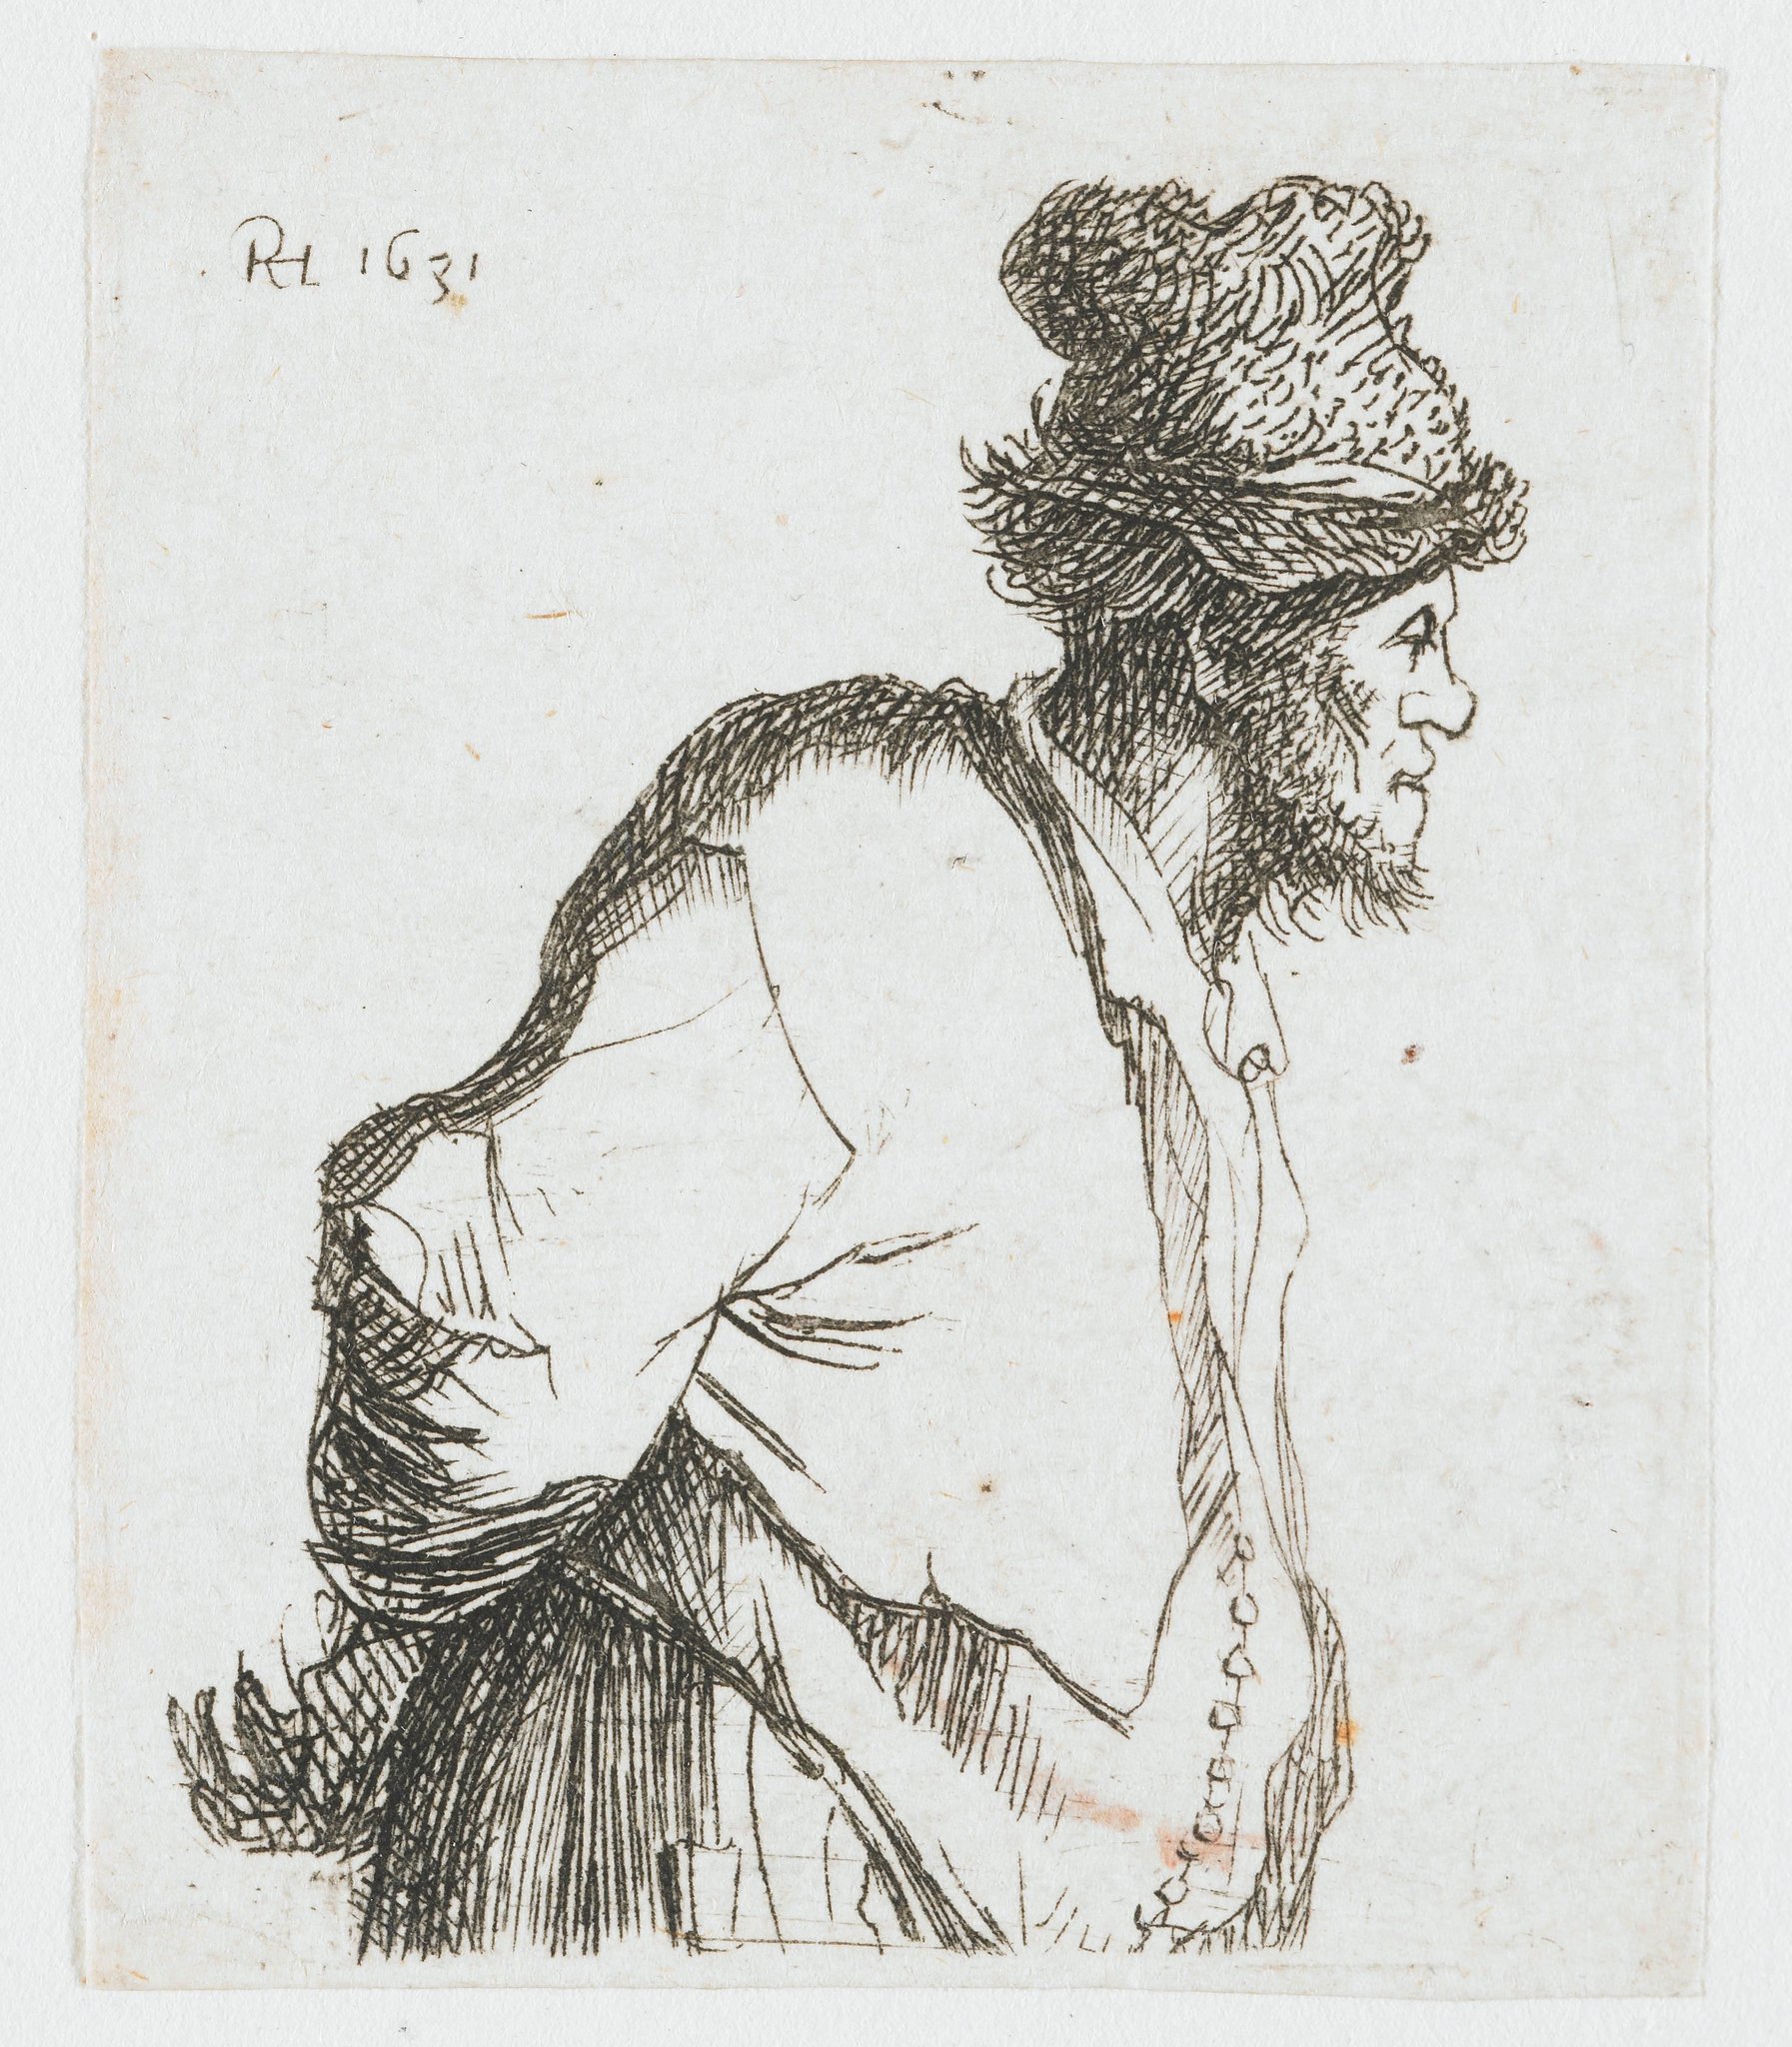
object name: print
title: Peasant with his hands behind his back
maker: rembrandt van rijn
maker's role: draughtsman, painter, print maker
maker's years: 1606-1669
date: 1629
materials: paper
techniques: etching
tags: adult man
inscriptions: collector's mark: Lugt 240, monogram and date: ‘RHL 1631’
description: De prent is gedateerd 1631, maar mogelijk niet door Rembrandt.